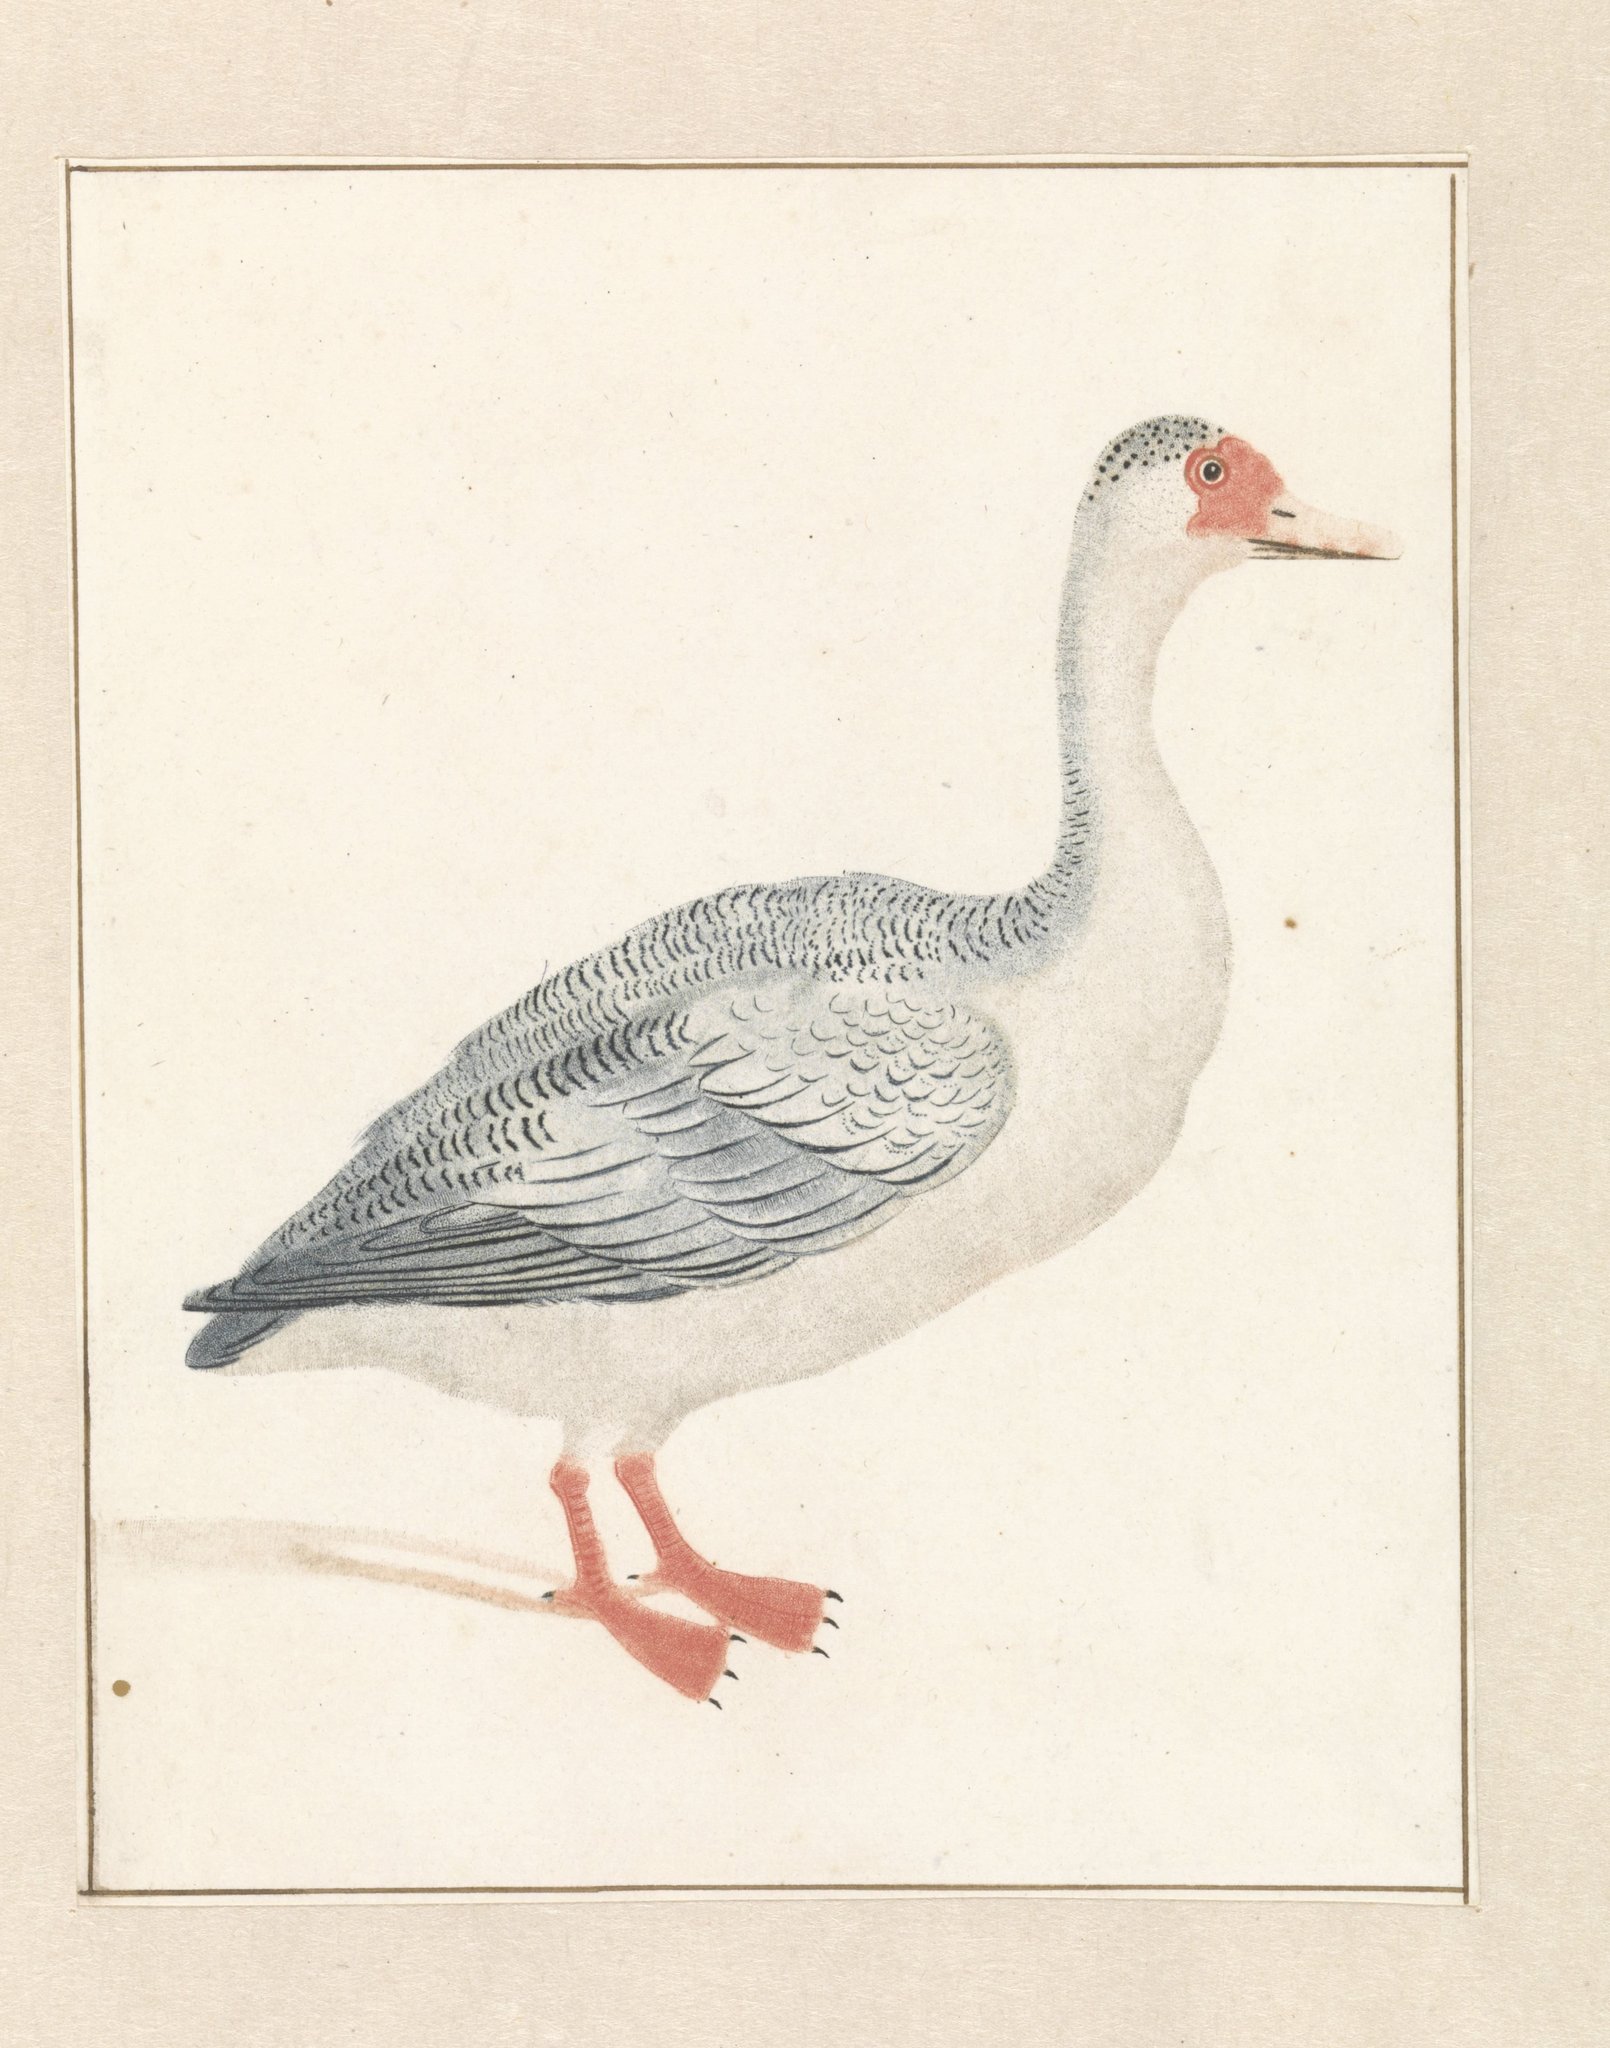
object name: print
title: Gans naar rechts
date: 1688-1698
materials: paper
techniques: etching, roulette, lithography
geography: netherlands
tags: water-birds: goose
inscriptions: collector's mark: Lugt 2228